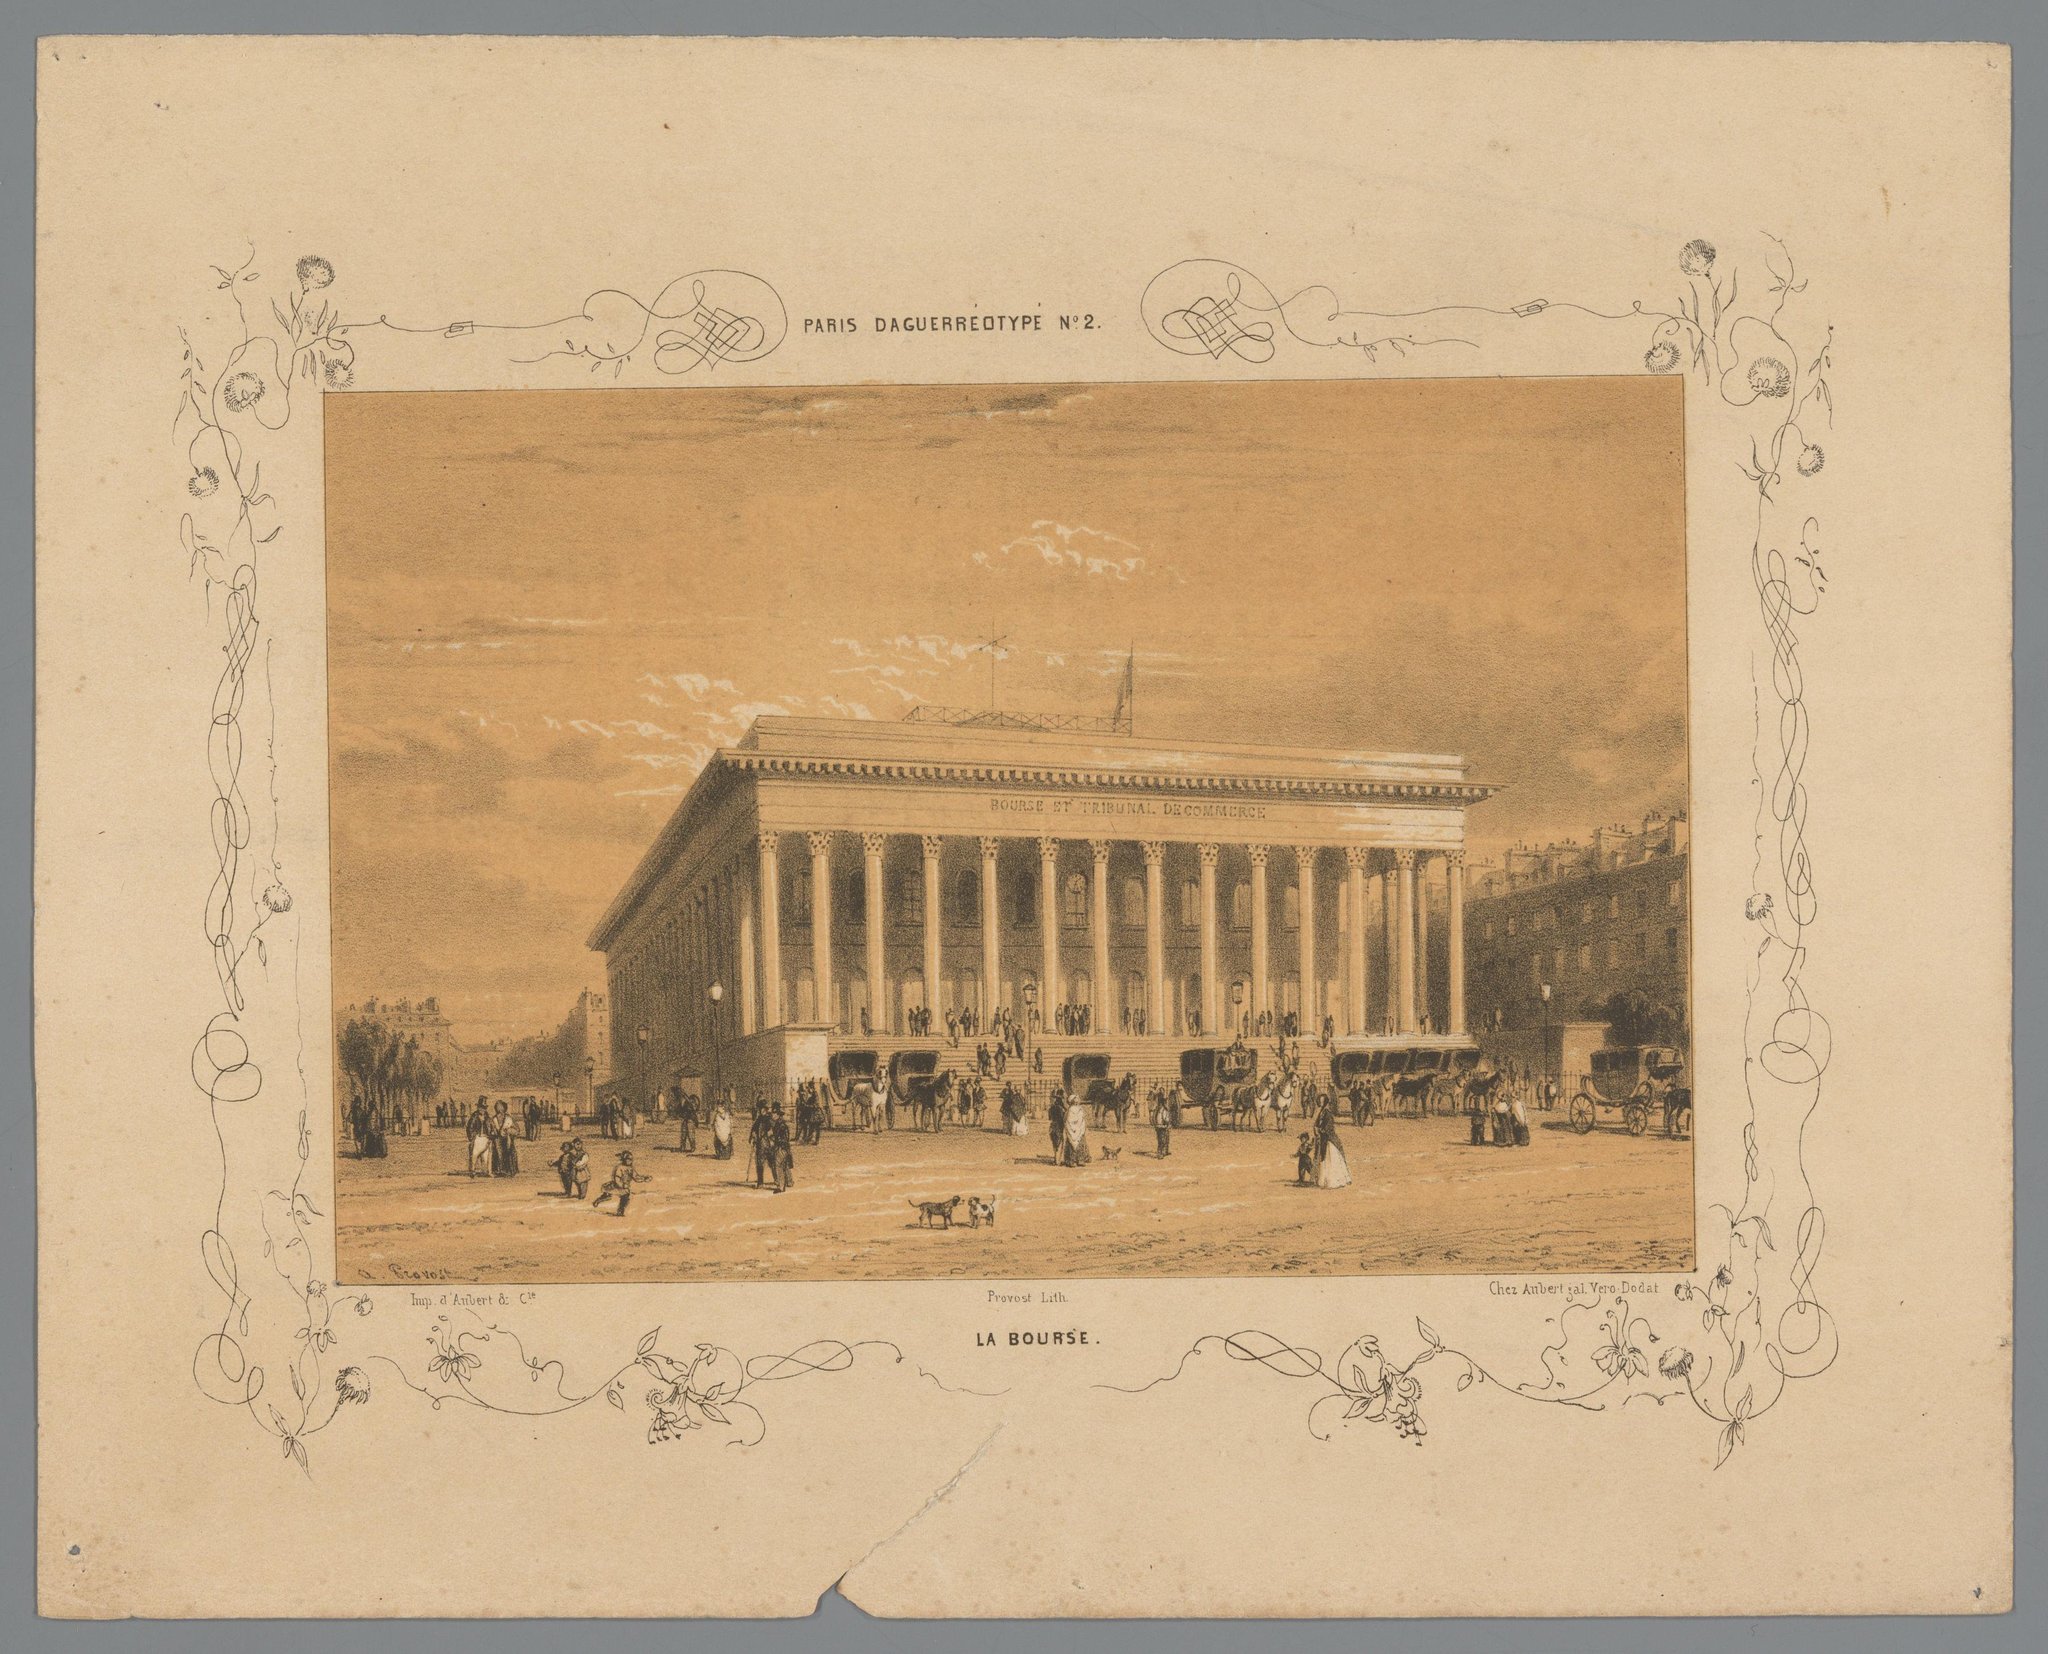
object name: print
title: La Bourse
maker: a. provost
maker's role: print maker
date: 1840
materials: paper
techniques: letterpress printing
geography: paris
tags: stock exchange, stock-market, paris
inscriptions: collector's mark: Lugt 2228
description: Prent uit: Philipon, Charles ed. Paris et ses environs reproduits par le daguerréotype, sous la direction de M. Ch. Philipon (…). Parijs: Aubert & Cie, 1840. Prent aangetroffen in een omslag voor een deel van de Nederlandse uitgave: Philipon, Charles ed. Parys en deszelfs omstreken, voorgesteld door de daguerréotype, onder toezigt van M. Ch. Philipon. Bewerkt naar het Fransch met de oorspronkelyke platen. Amsterdam: Elix & Co., 1840-1842. Deze uitgave is in delen uitgegeven en kon uiteindelijk tot een boek worden ingebonden.